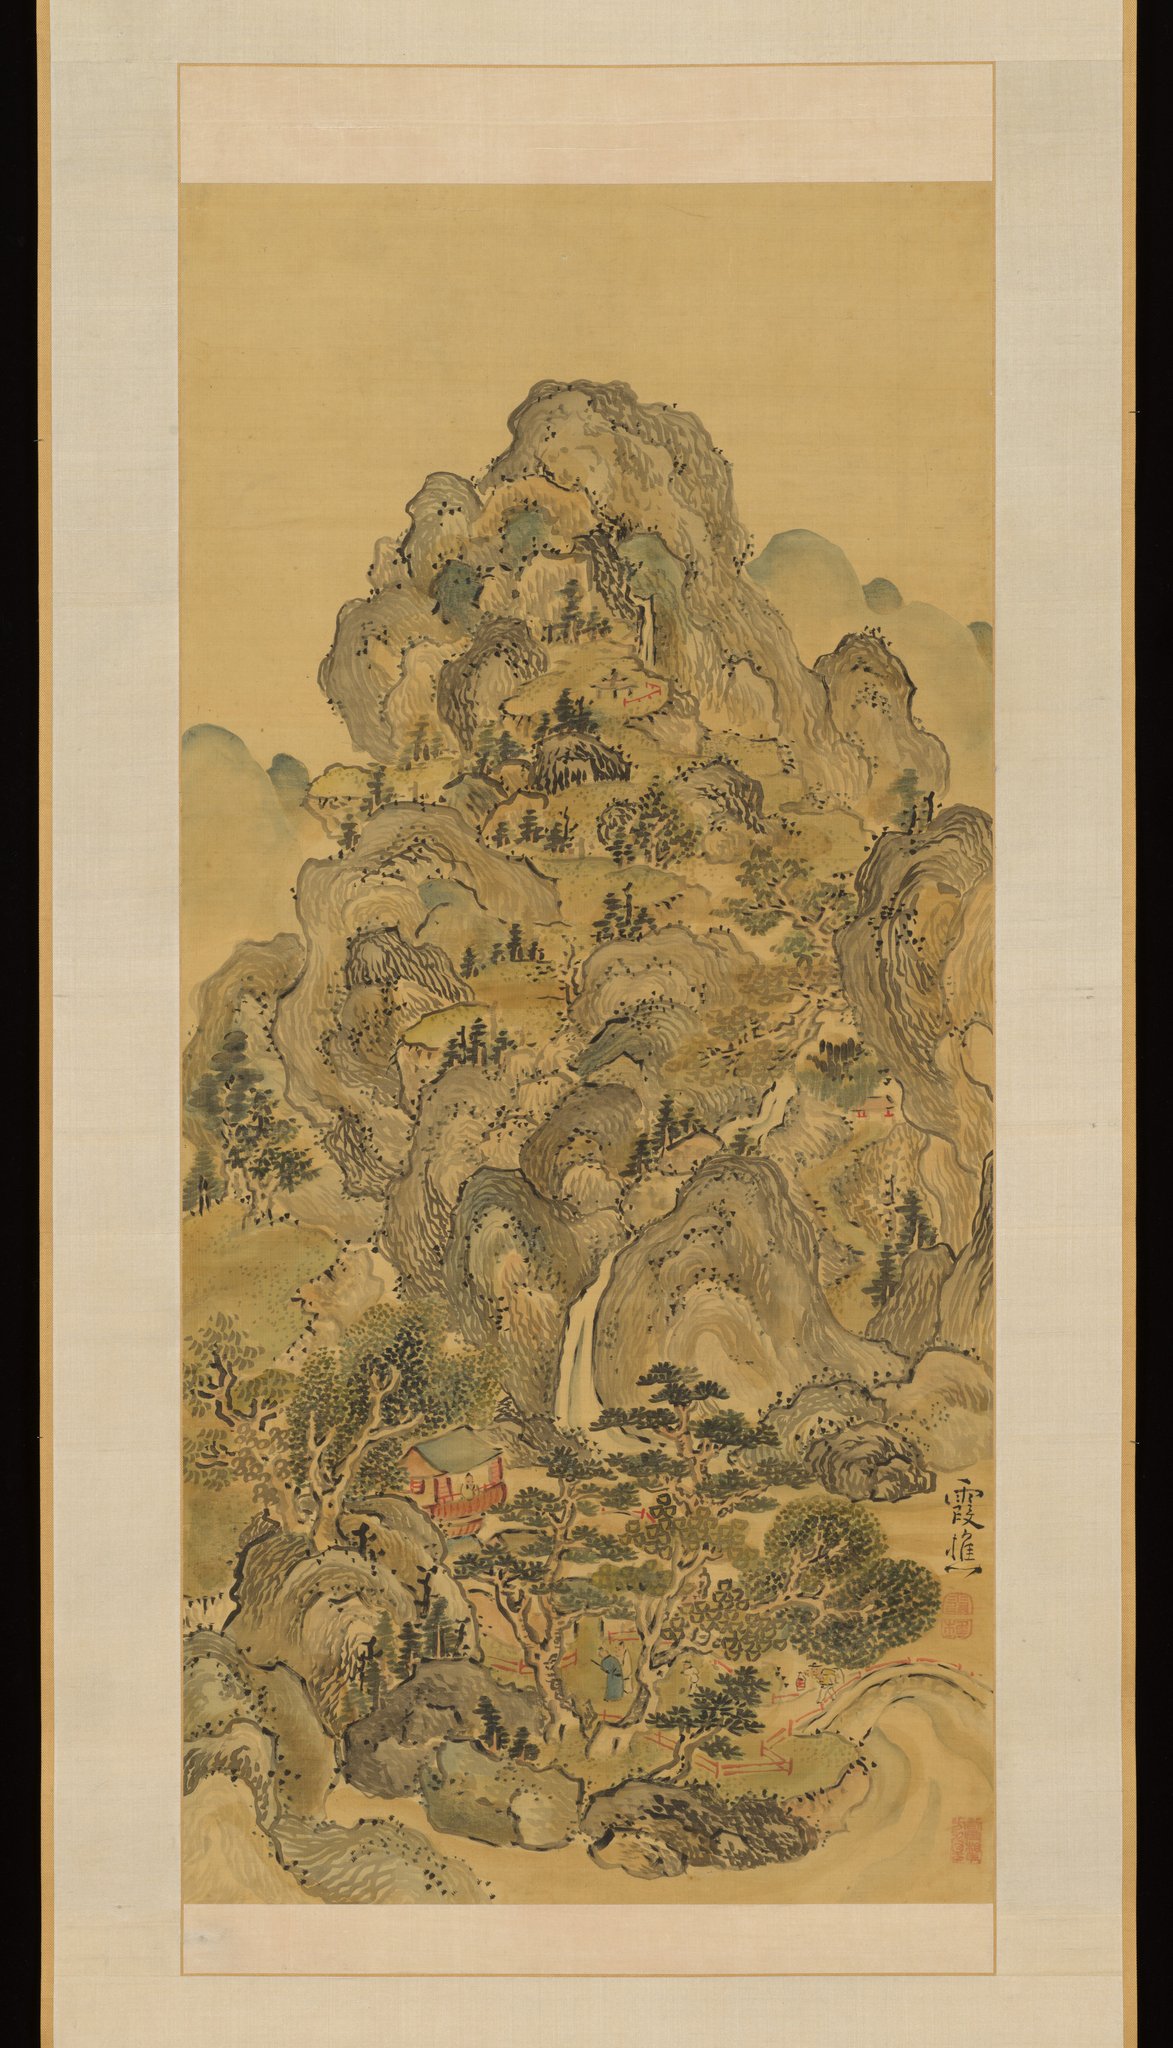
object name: hanging scroll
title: Landscapes in Summer and Winter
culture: japanese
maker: ike no taiga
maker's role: artist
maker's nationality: japanese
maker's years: 1723-1776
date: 1701-1800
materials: ink, silk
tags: mountains,landscapes